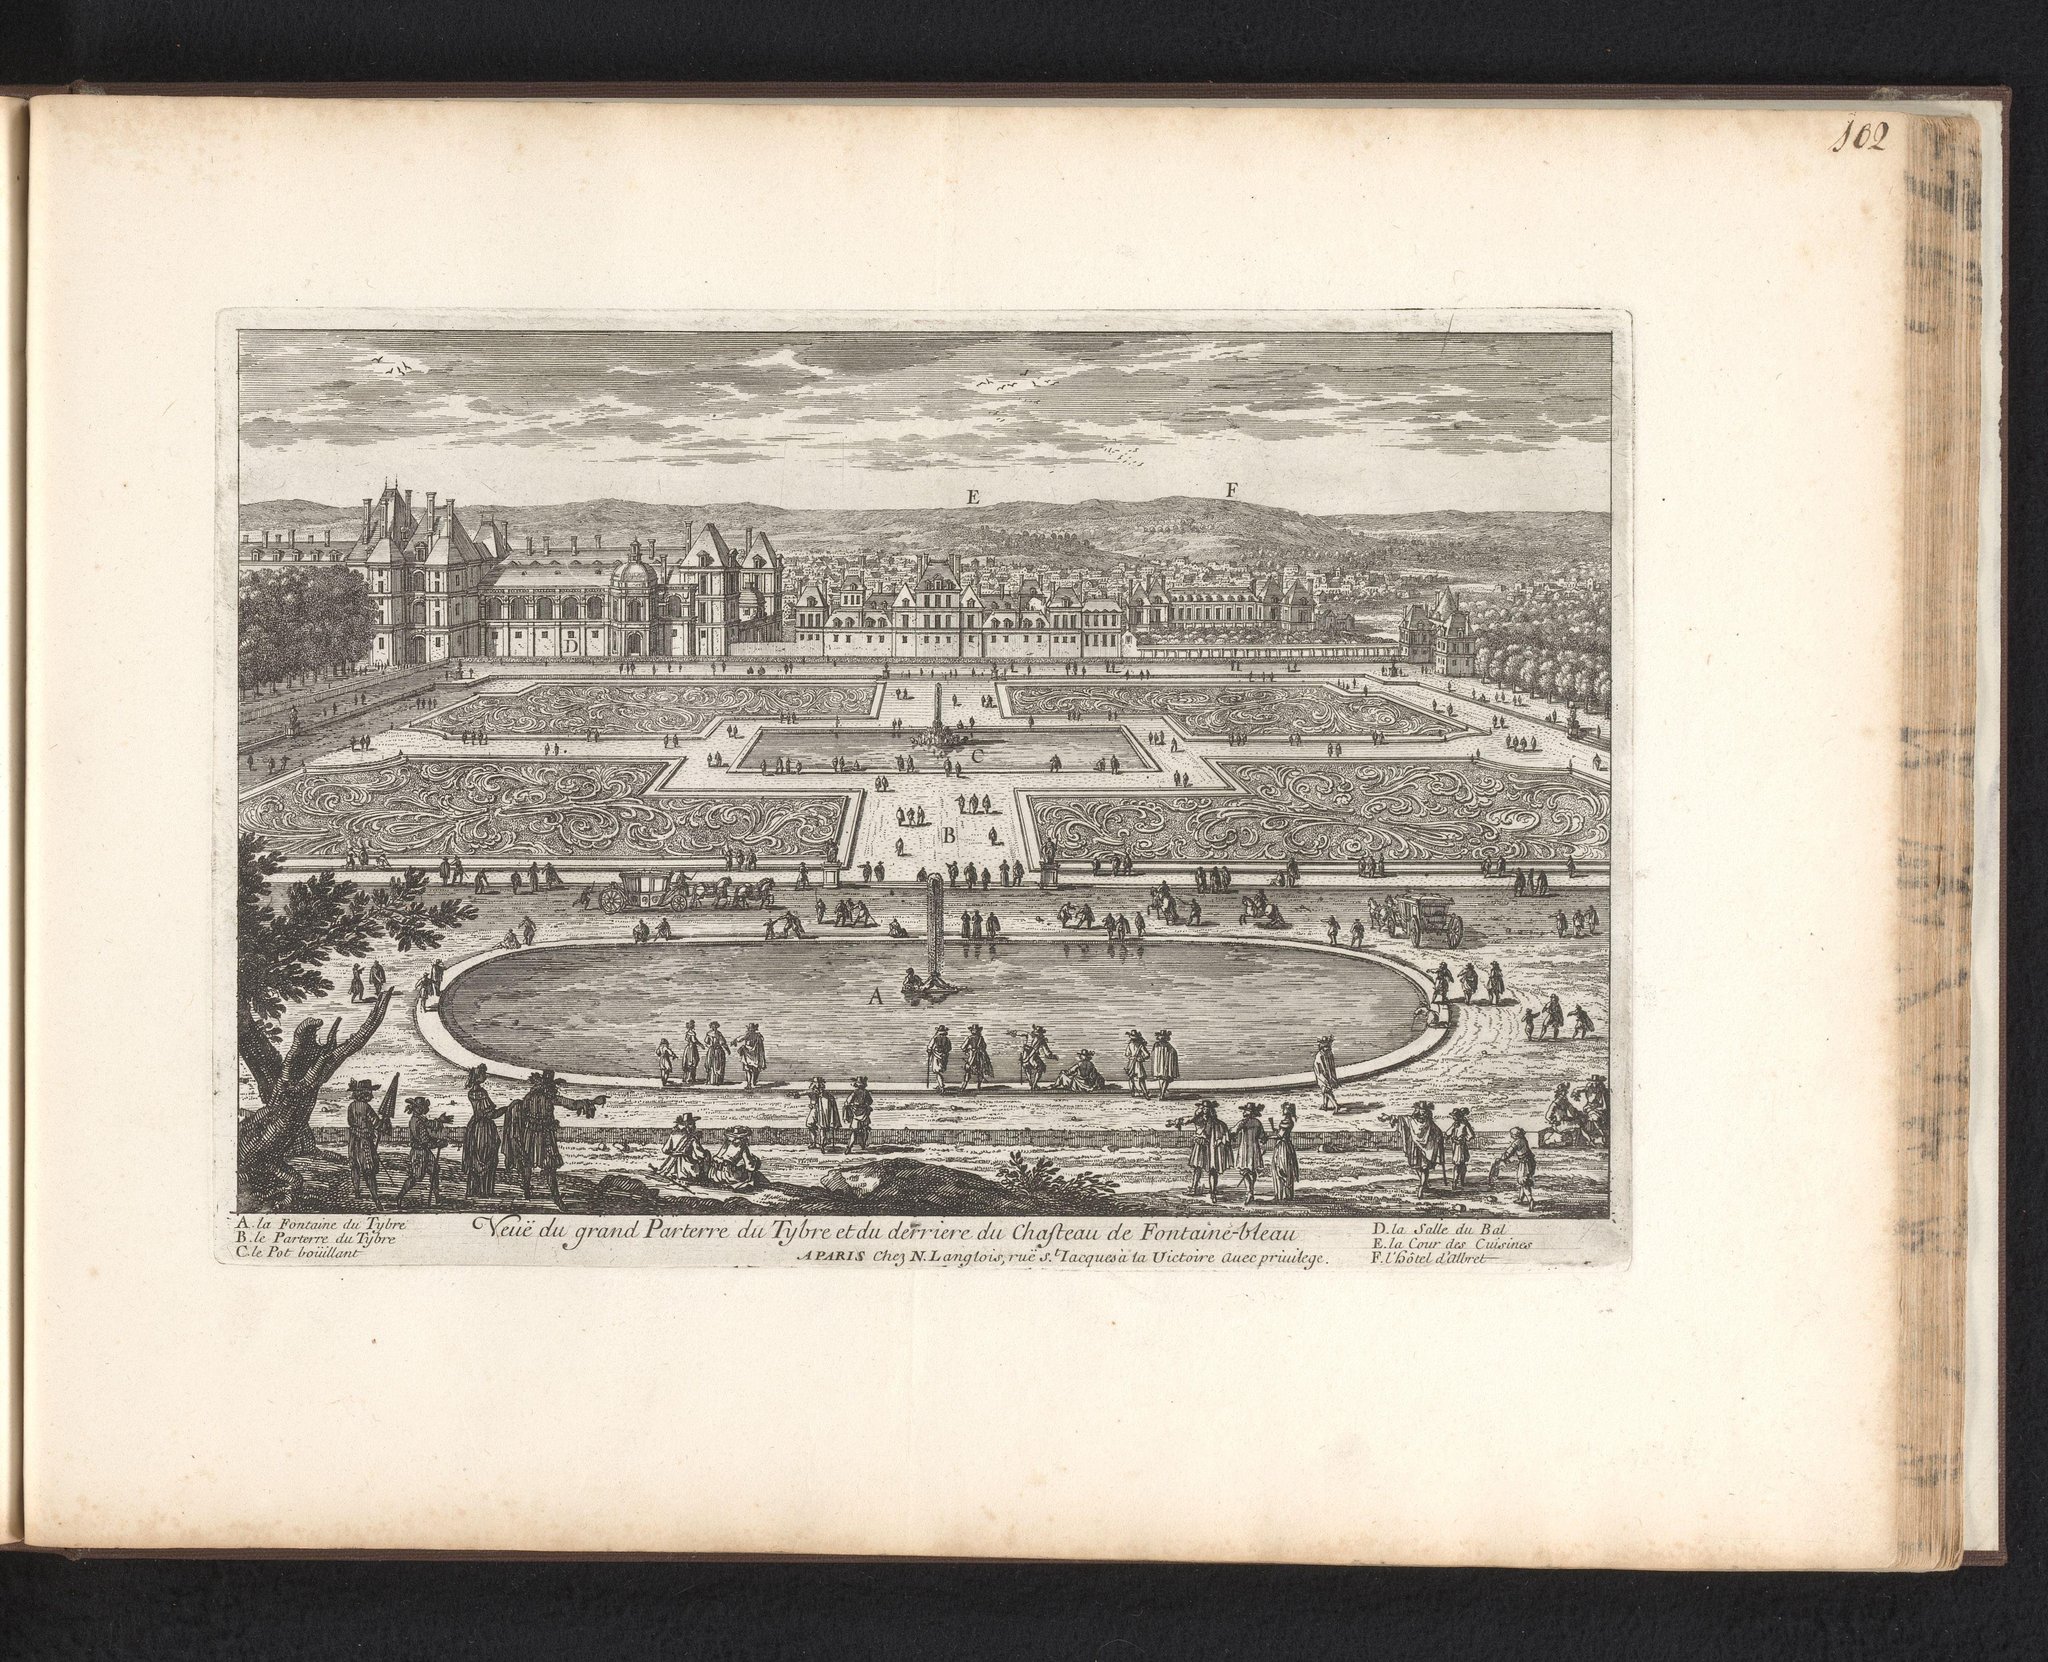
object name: print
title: Recueil de vues de monuments de Paris, des principales résidences royales et des principaux châteaux de France et de Rome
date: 1660-1703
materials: paper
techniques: etching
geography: paris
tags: french or architectonic garden; formal garden, landscape with tower or castle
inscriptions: collector's mark: Lugt 2228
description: Prenten met het signatuur 'Perelle' kunnen zowel door vader Gabriel als door zonen Nicolas en Adam gemaakt zijn. De uitgevers vader en zoon Nicolas Langlois worden allebei vermeld als N. Langlois op hetzelfde adres.